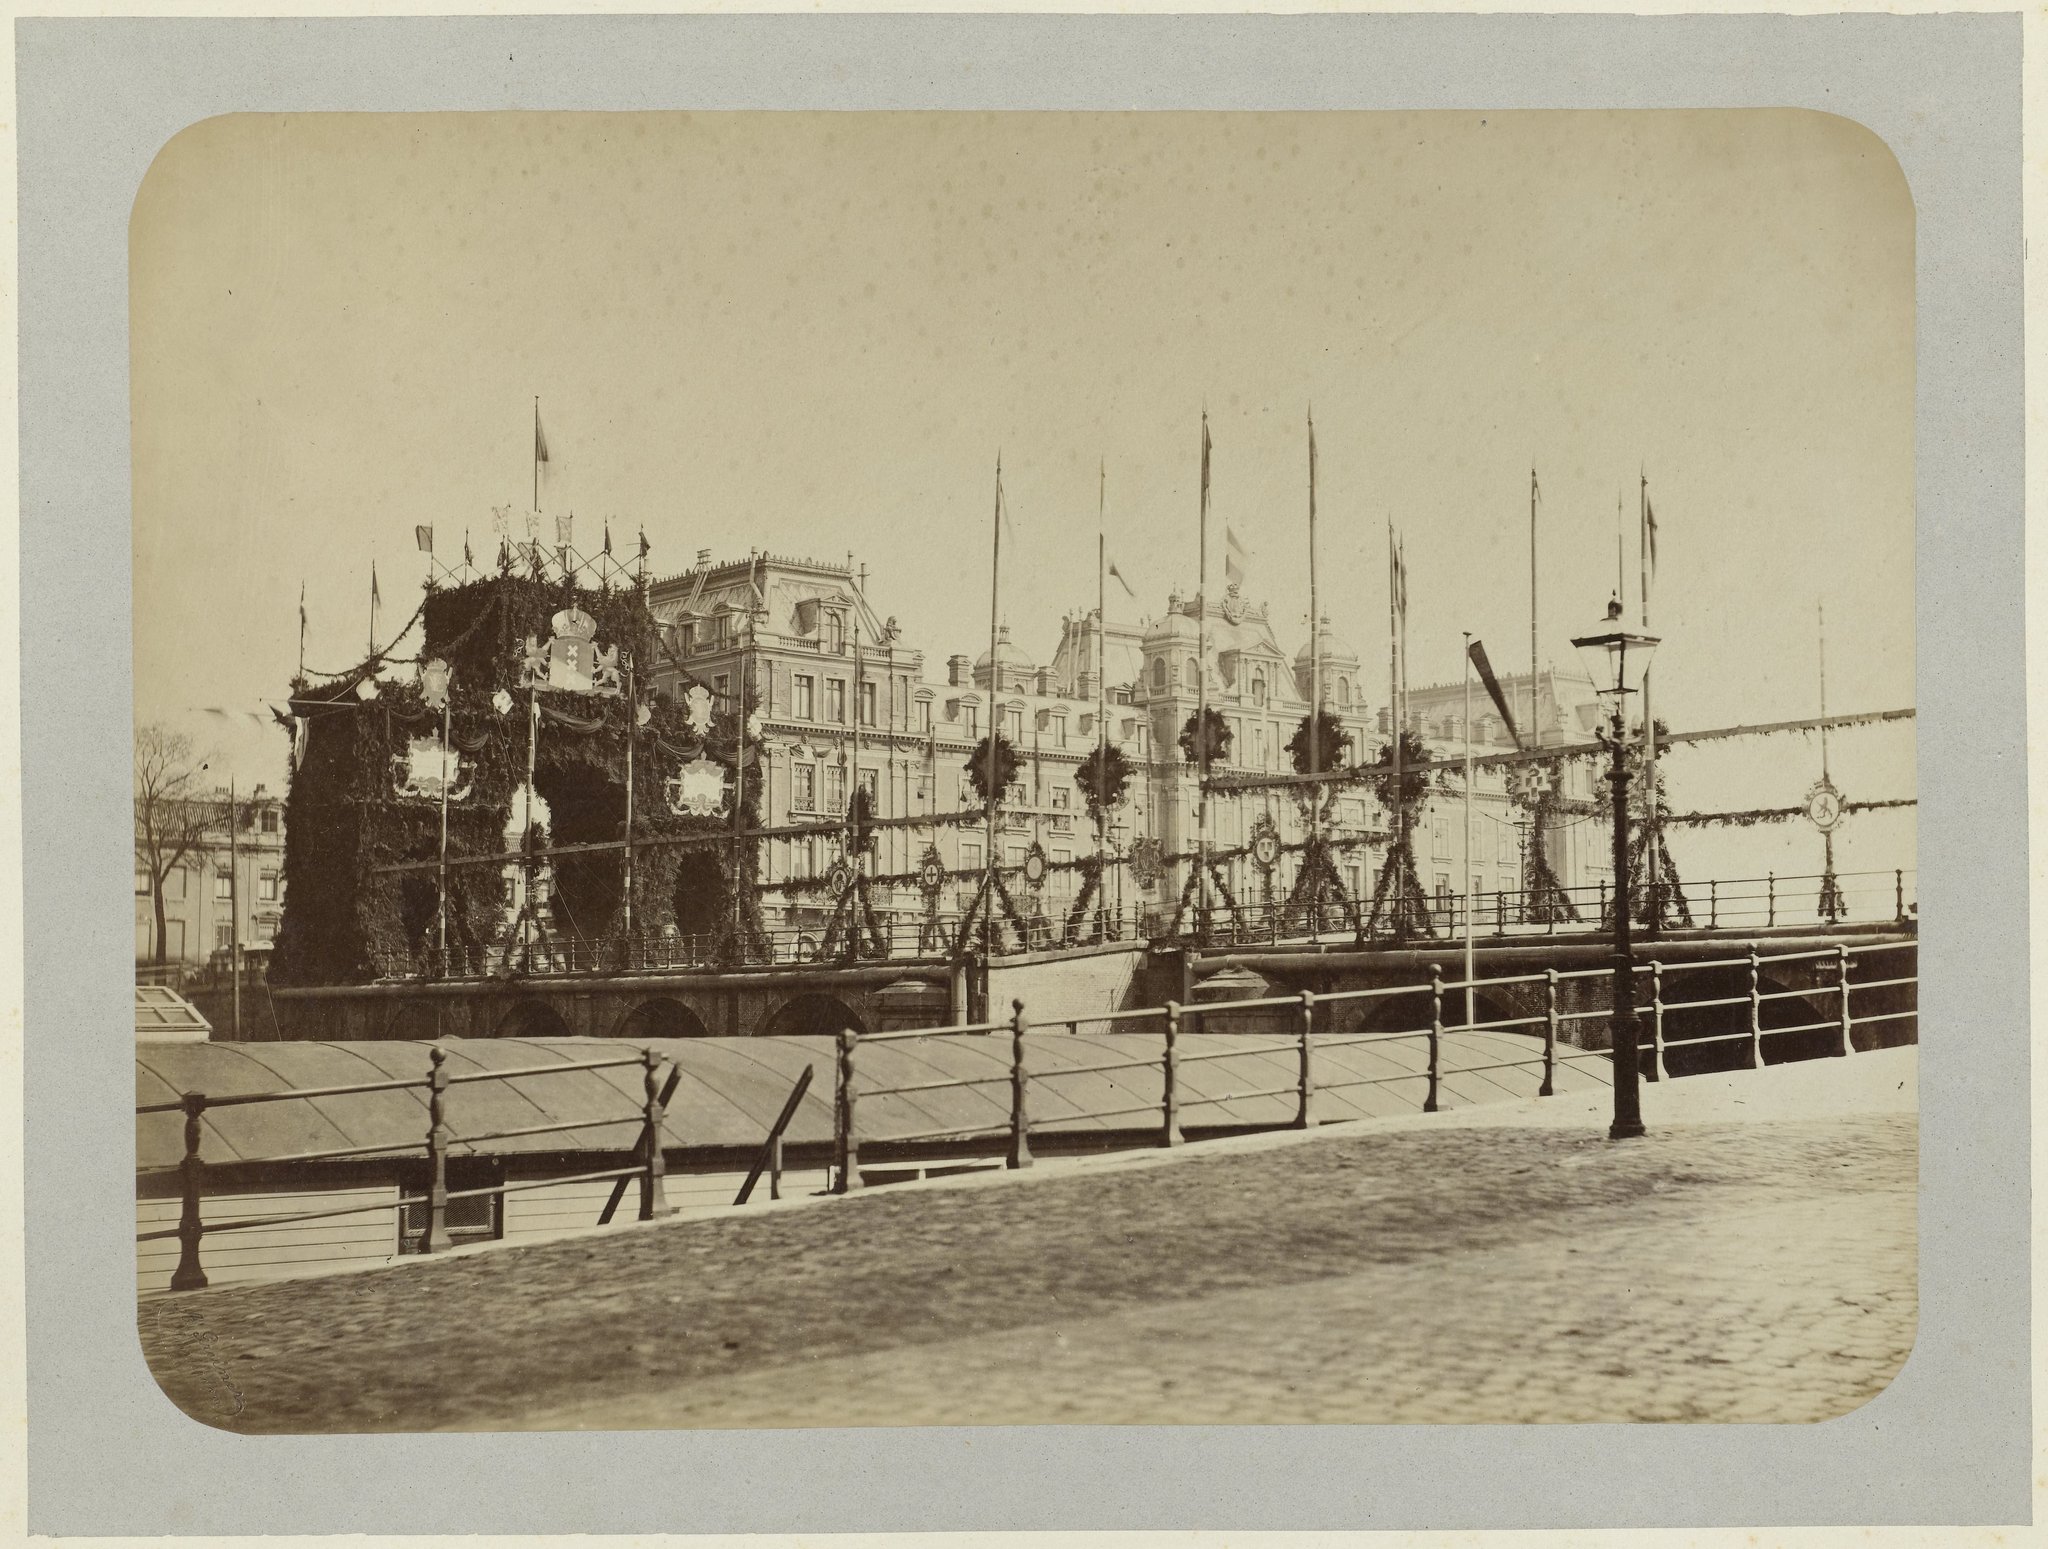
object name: photograph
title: Decoratie bij de Hogesluis voor de ontvangst van Willem III en Emma in Amsterdam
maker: albert greiner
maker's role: fotograaf, fotostudio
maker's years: 1833-1890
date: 1879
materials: paper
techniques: albumen print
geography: amsterdam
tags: the hague, emma (queen consort of the netherlands), brussels, willem iii (koning der nederlanden), festivities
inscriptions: title: ‘Amsterdam Amstel Hotel 1878 huwelijk Willem III - Emma’, name: ‘A. Greiner Amsterdam’